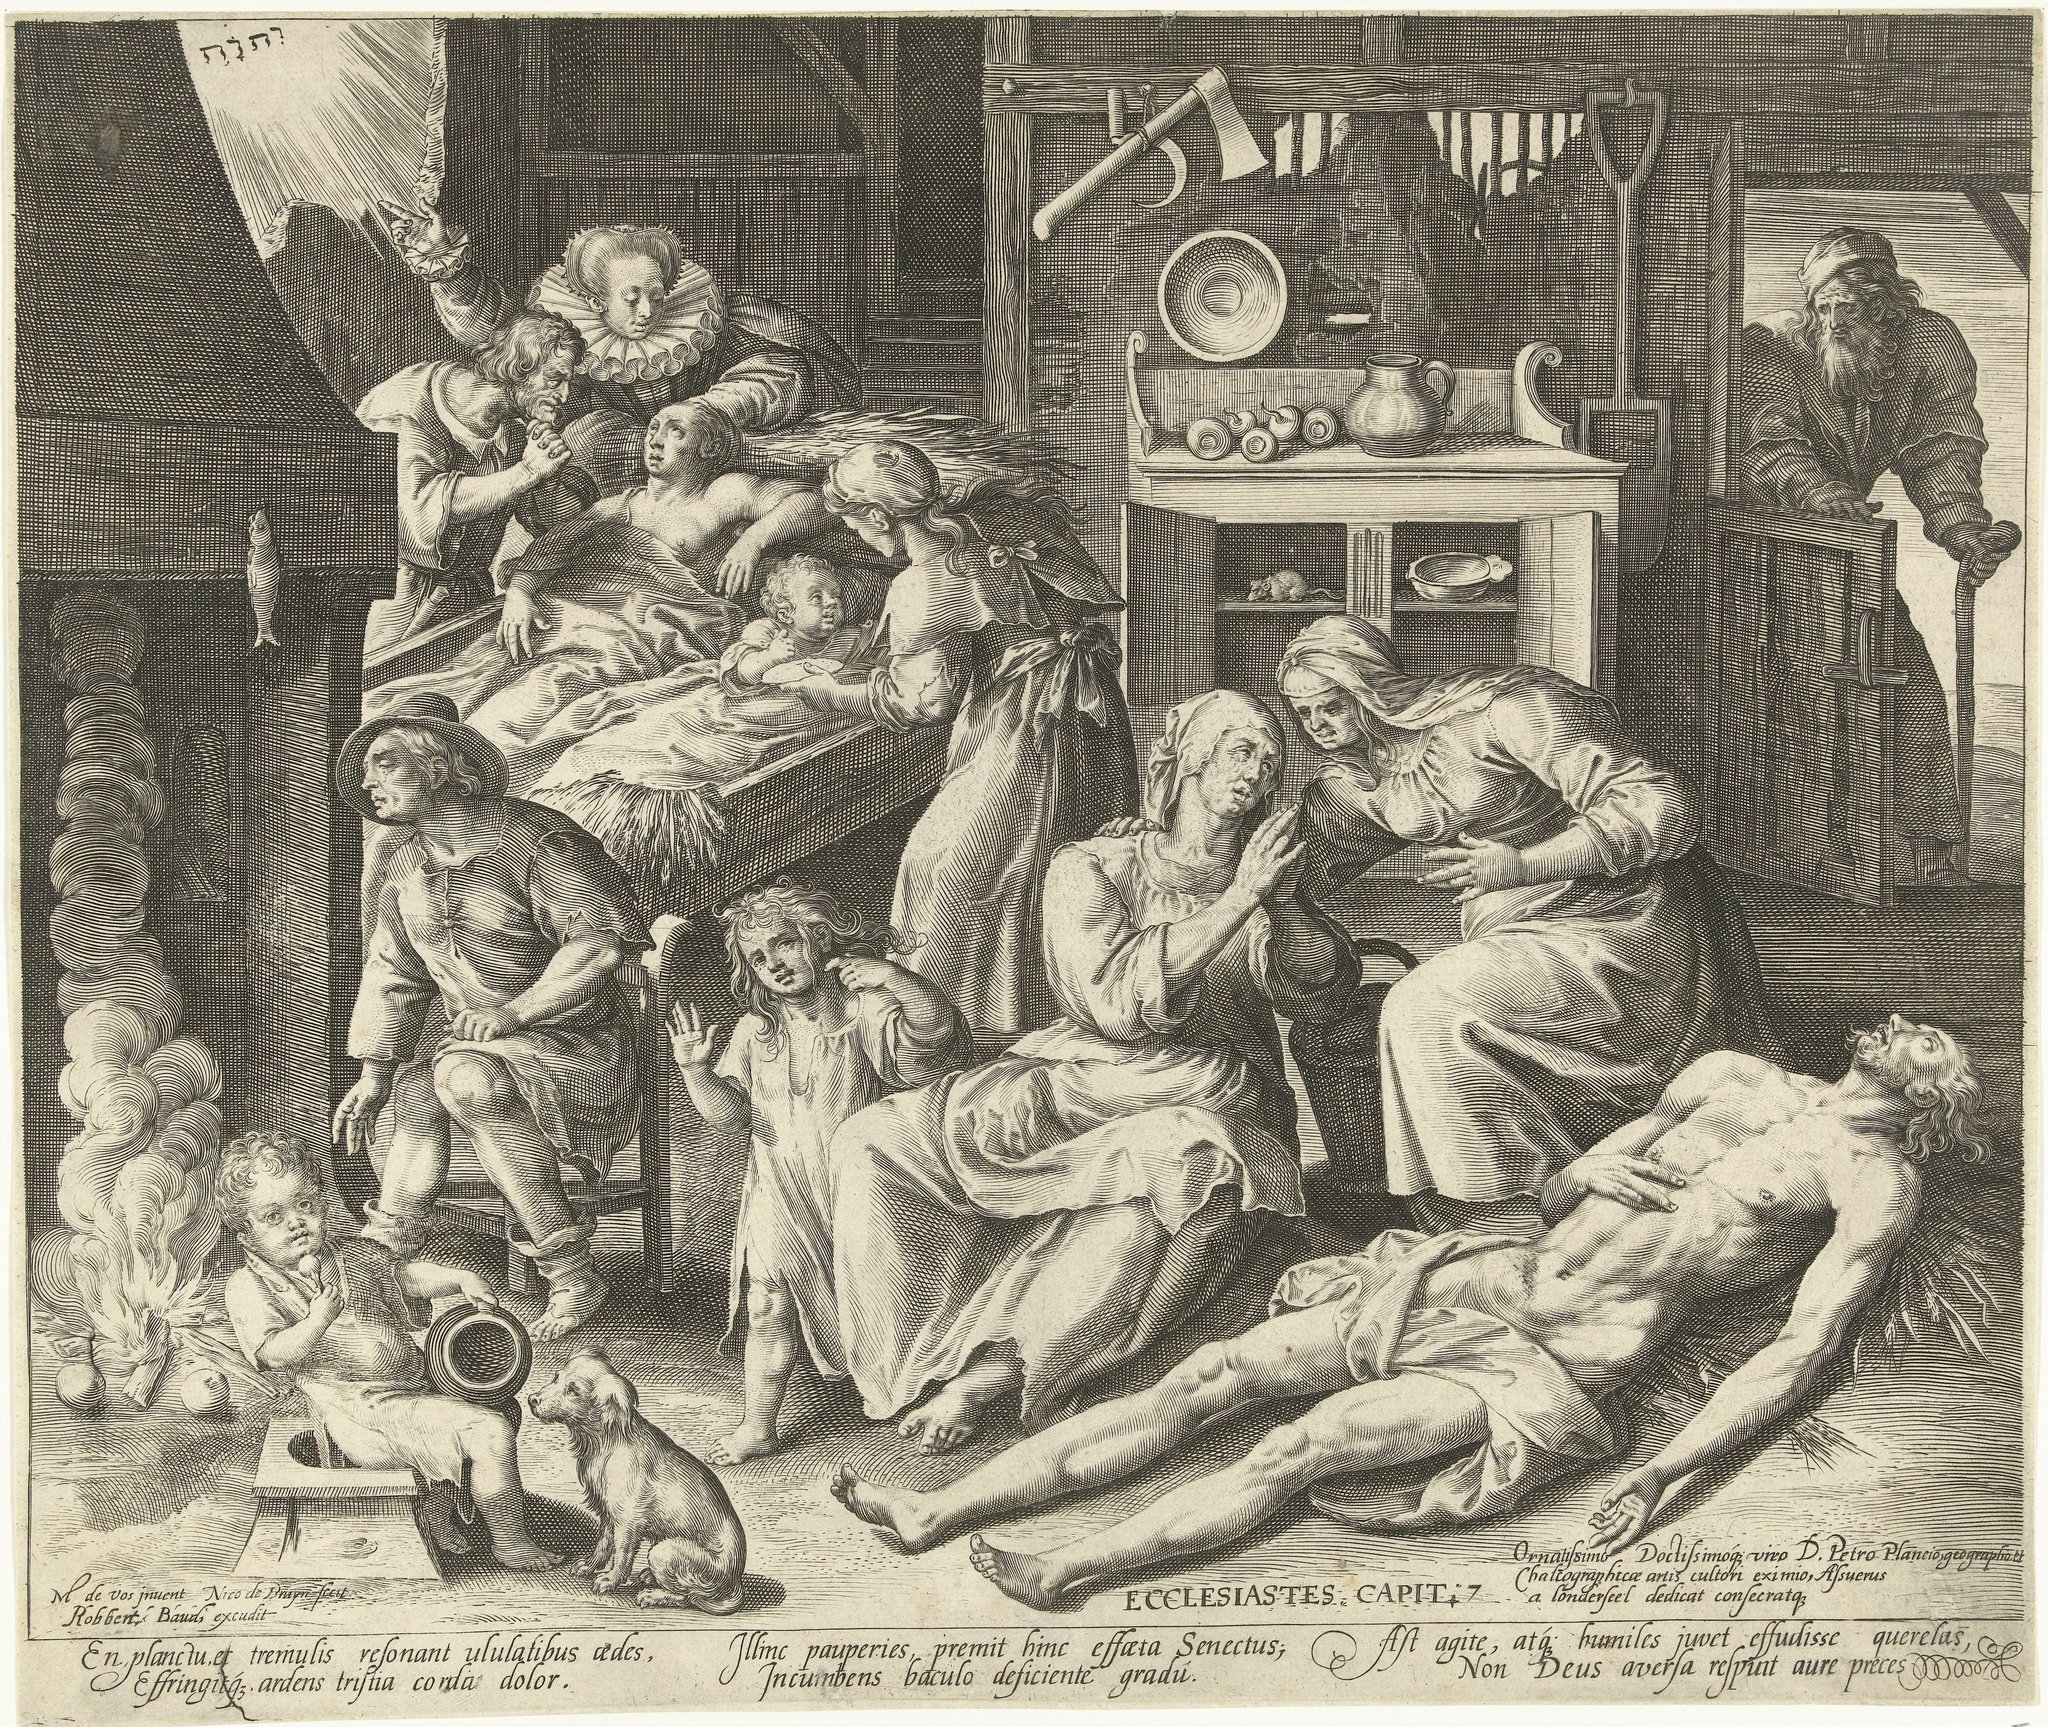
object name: print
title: Een huis vol rouw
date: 1581-1656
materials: paper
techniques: engraving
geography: netherlands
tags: deathbed, mourning the dead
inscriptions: collector's mark: Lugt 2228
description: Verbeelding van één van de wijsheden volgens het boek Prediker (nr. 7). In een interieur rouwen familieleden om overledenen, een fase in het leven van ieder mens. Volgens Prediker moeten we droevigheid nastreven omdat het ons hart goed doet. De man die door de geopende deur binnenstapt neemt mogelijk deze wijsheid ter harte en betreedt een huis vol rouw. In de marge onder een vers met zes regels Latijn.